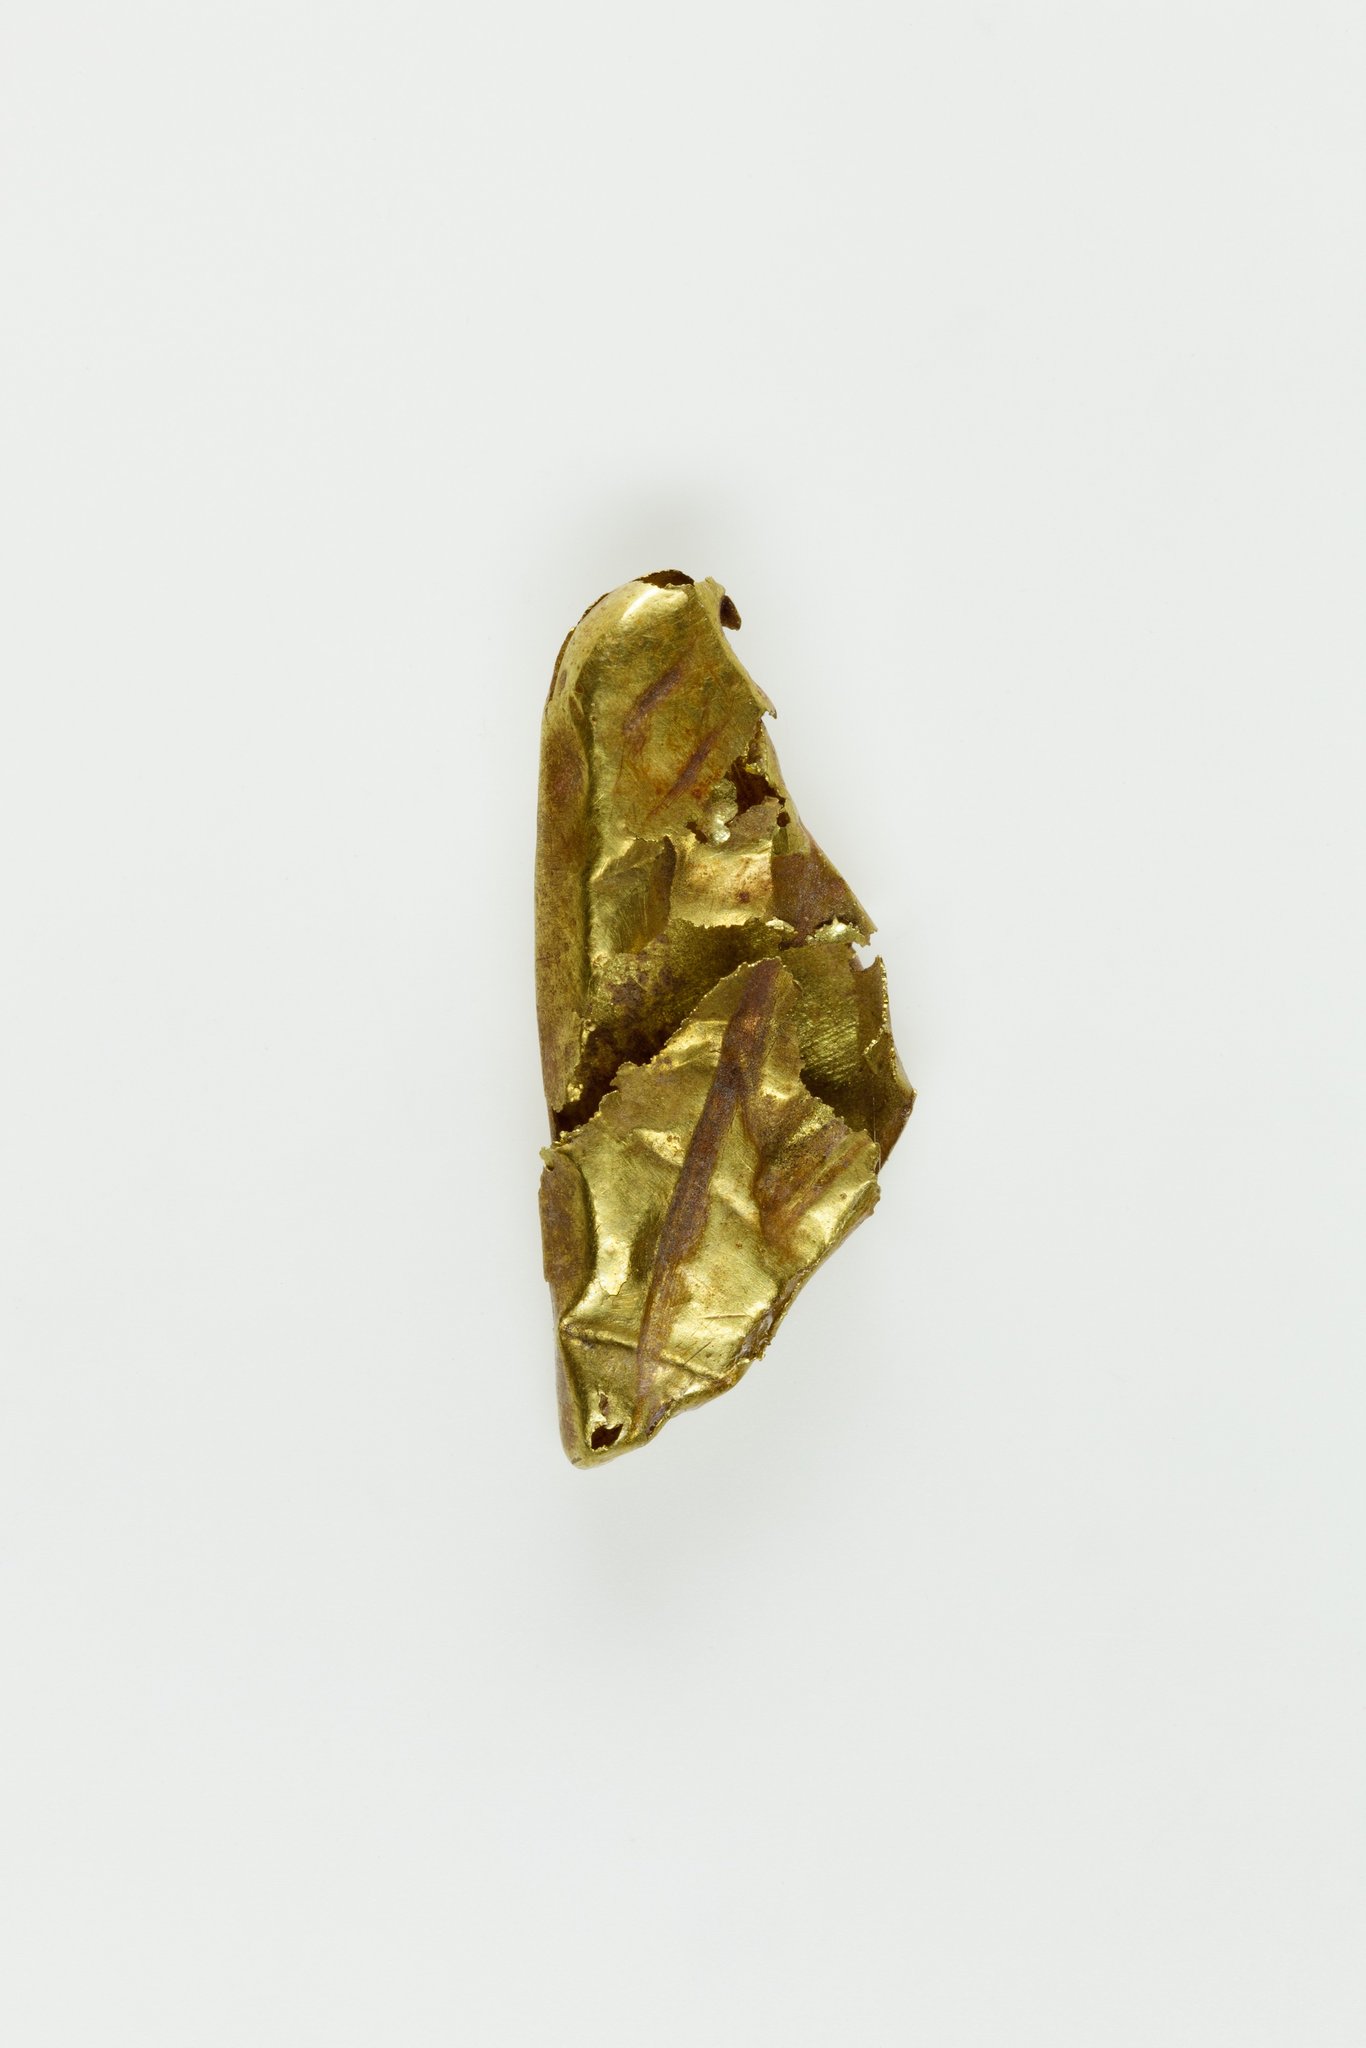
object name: amulet, falcon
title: Falcon amulet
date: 1850-1640 BCE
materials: gold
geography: egypt